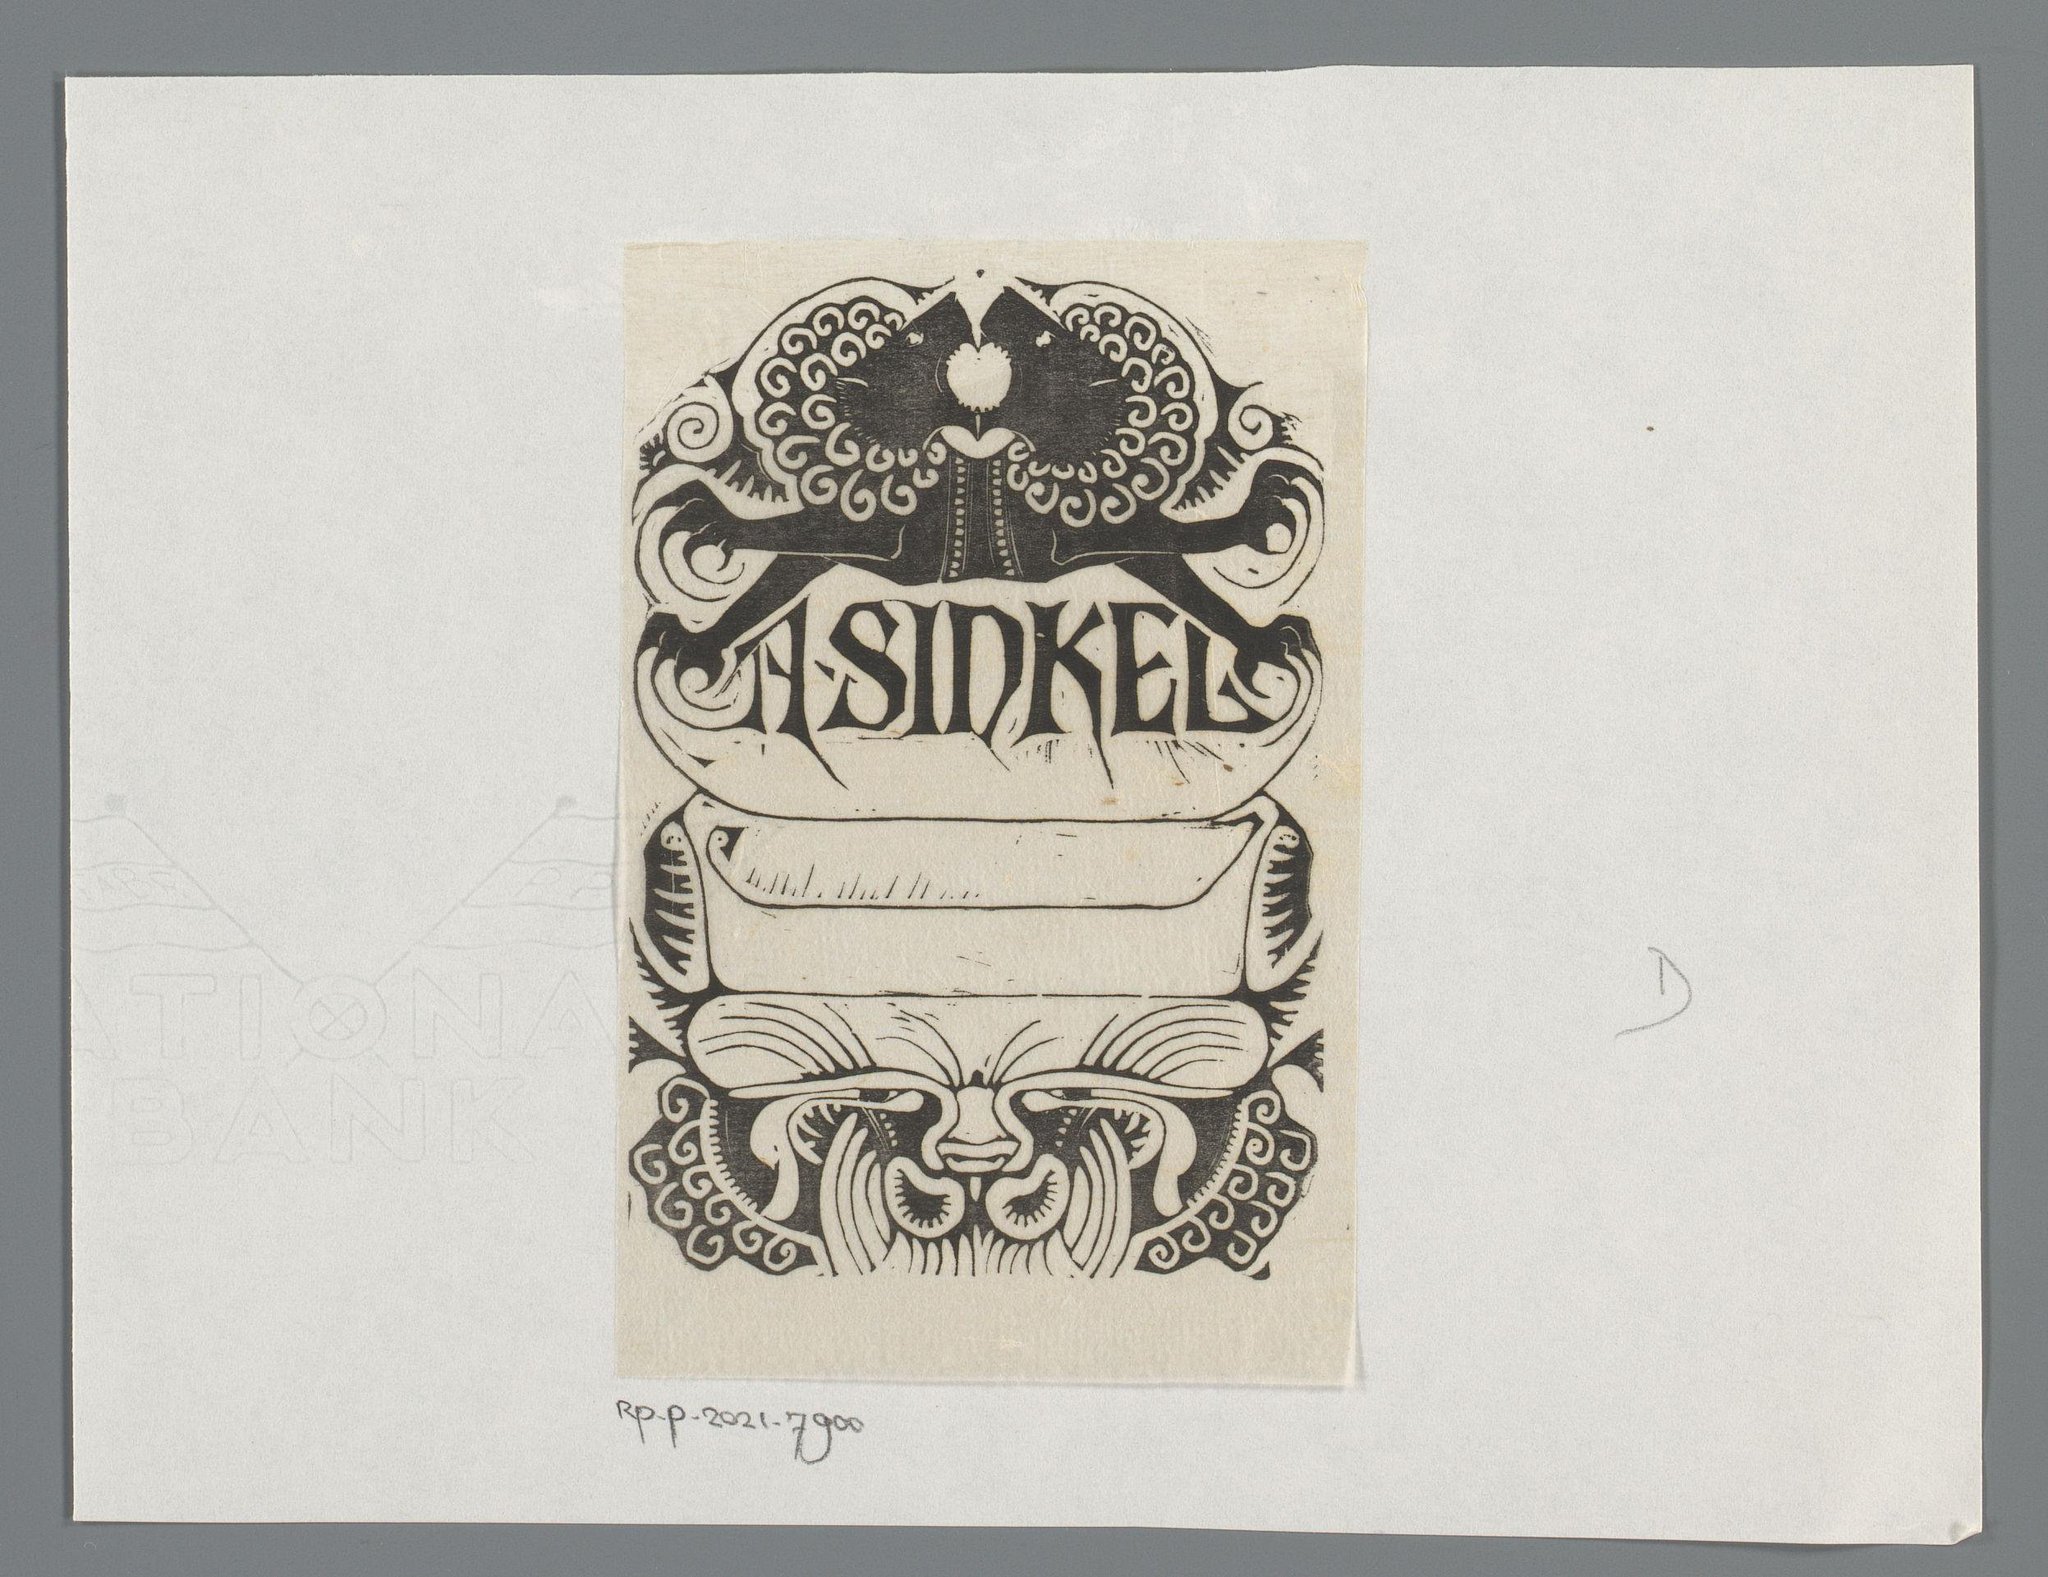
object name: print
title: Etiket van A. Sinkel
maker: mathieu lauweriks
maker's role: designer, draughtsman, print maker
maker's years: 1864-1932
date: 1874-1932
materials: paper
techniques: woodcut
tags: mask, insects: butterfly, beasts of prey, predatory animals: lion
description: Bovenaan twee leeuwen, onderaan een vlinder of masker.